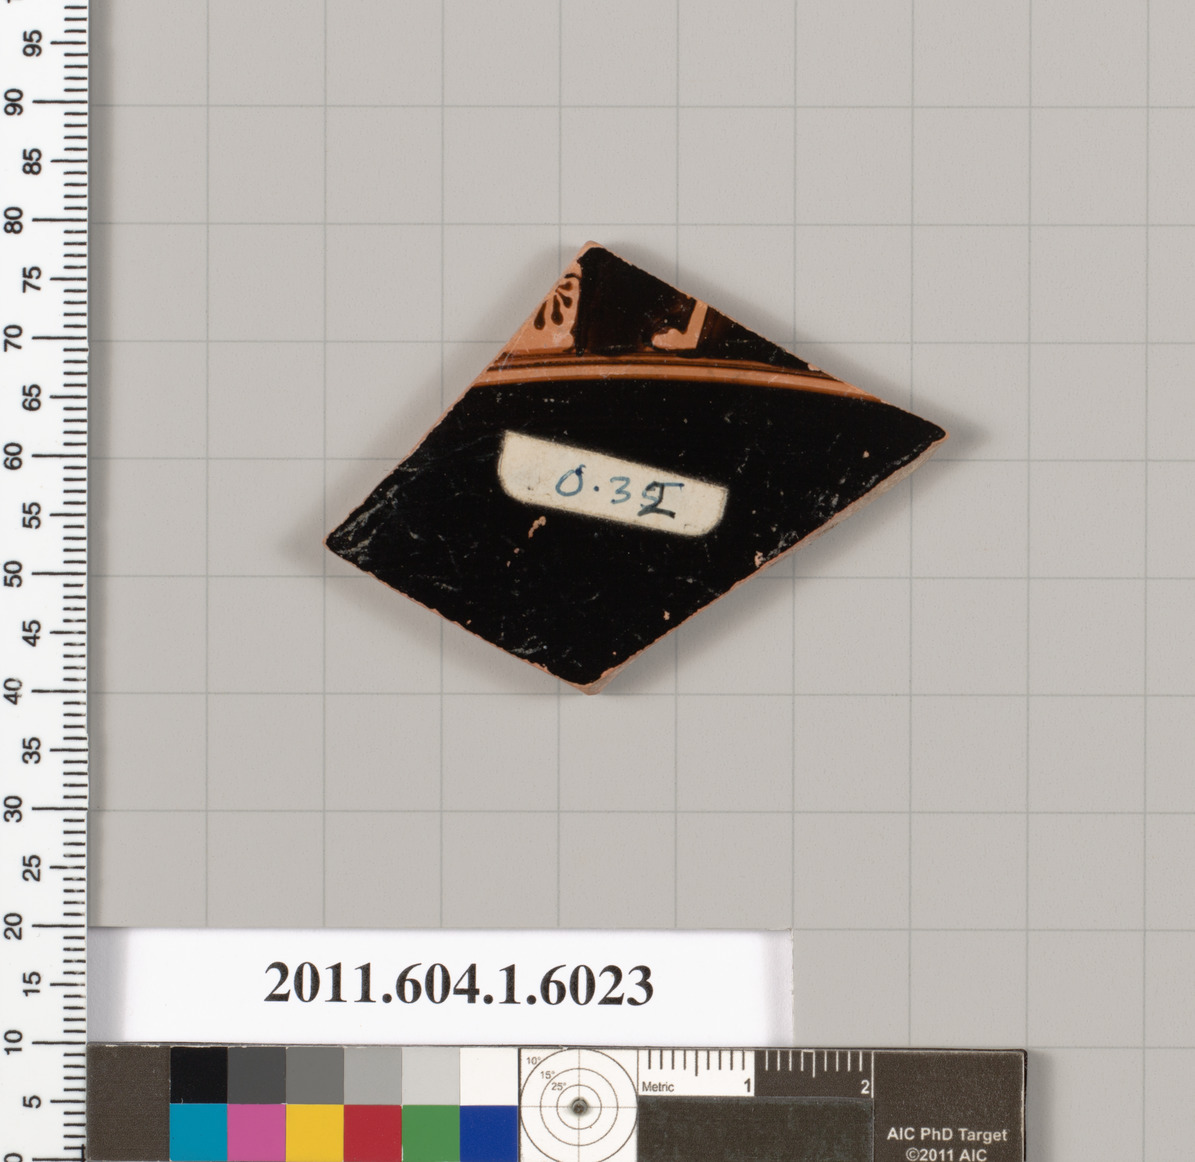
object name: kylix fragment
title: Terracotta fragment of a kylix (drinking cup)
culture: greek, attic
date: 510-500 BCE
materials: terracotta